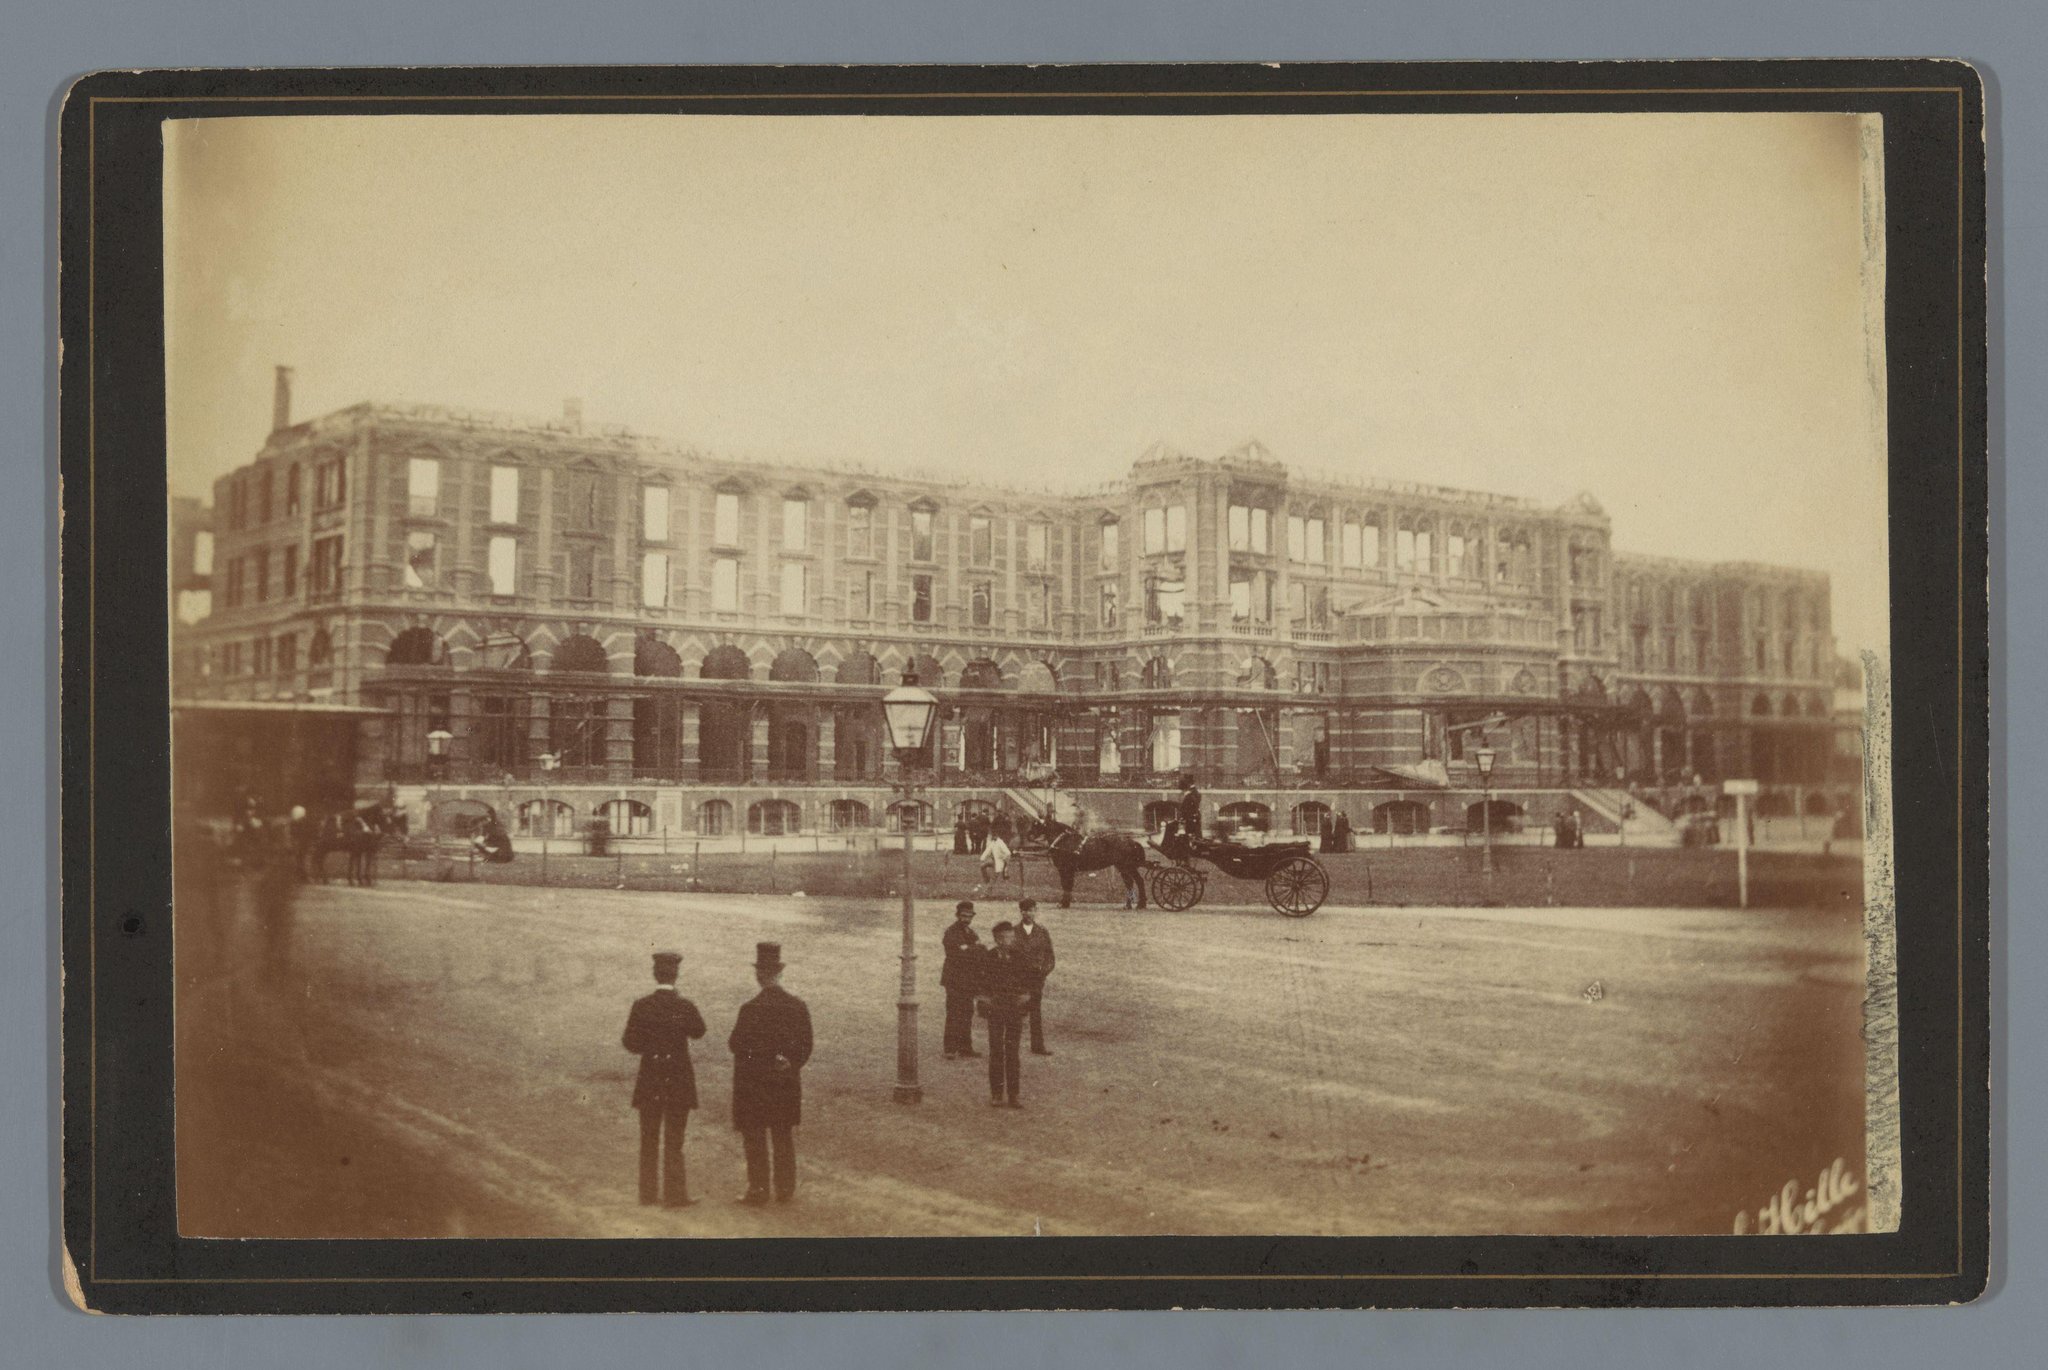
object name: photograph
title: Gevel van het door brand verwoeste Kurhaus te Scheveningen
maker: h. hille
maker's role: fotograaf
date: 1886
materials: cardboard, photographic support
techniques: albumen print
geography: scheveningen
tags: ruin of a building ~ architecture, façade (of house or building), hotel, hostelry, inn